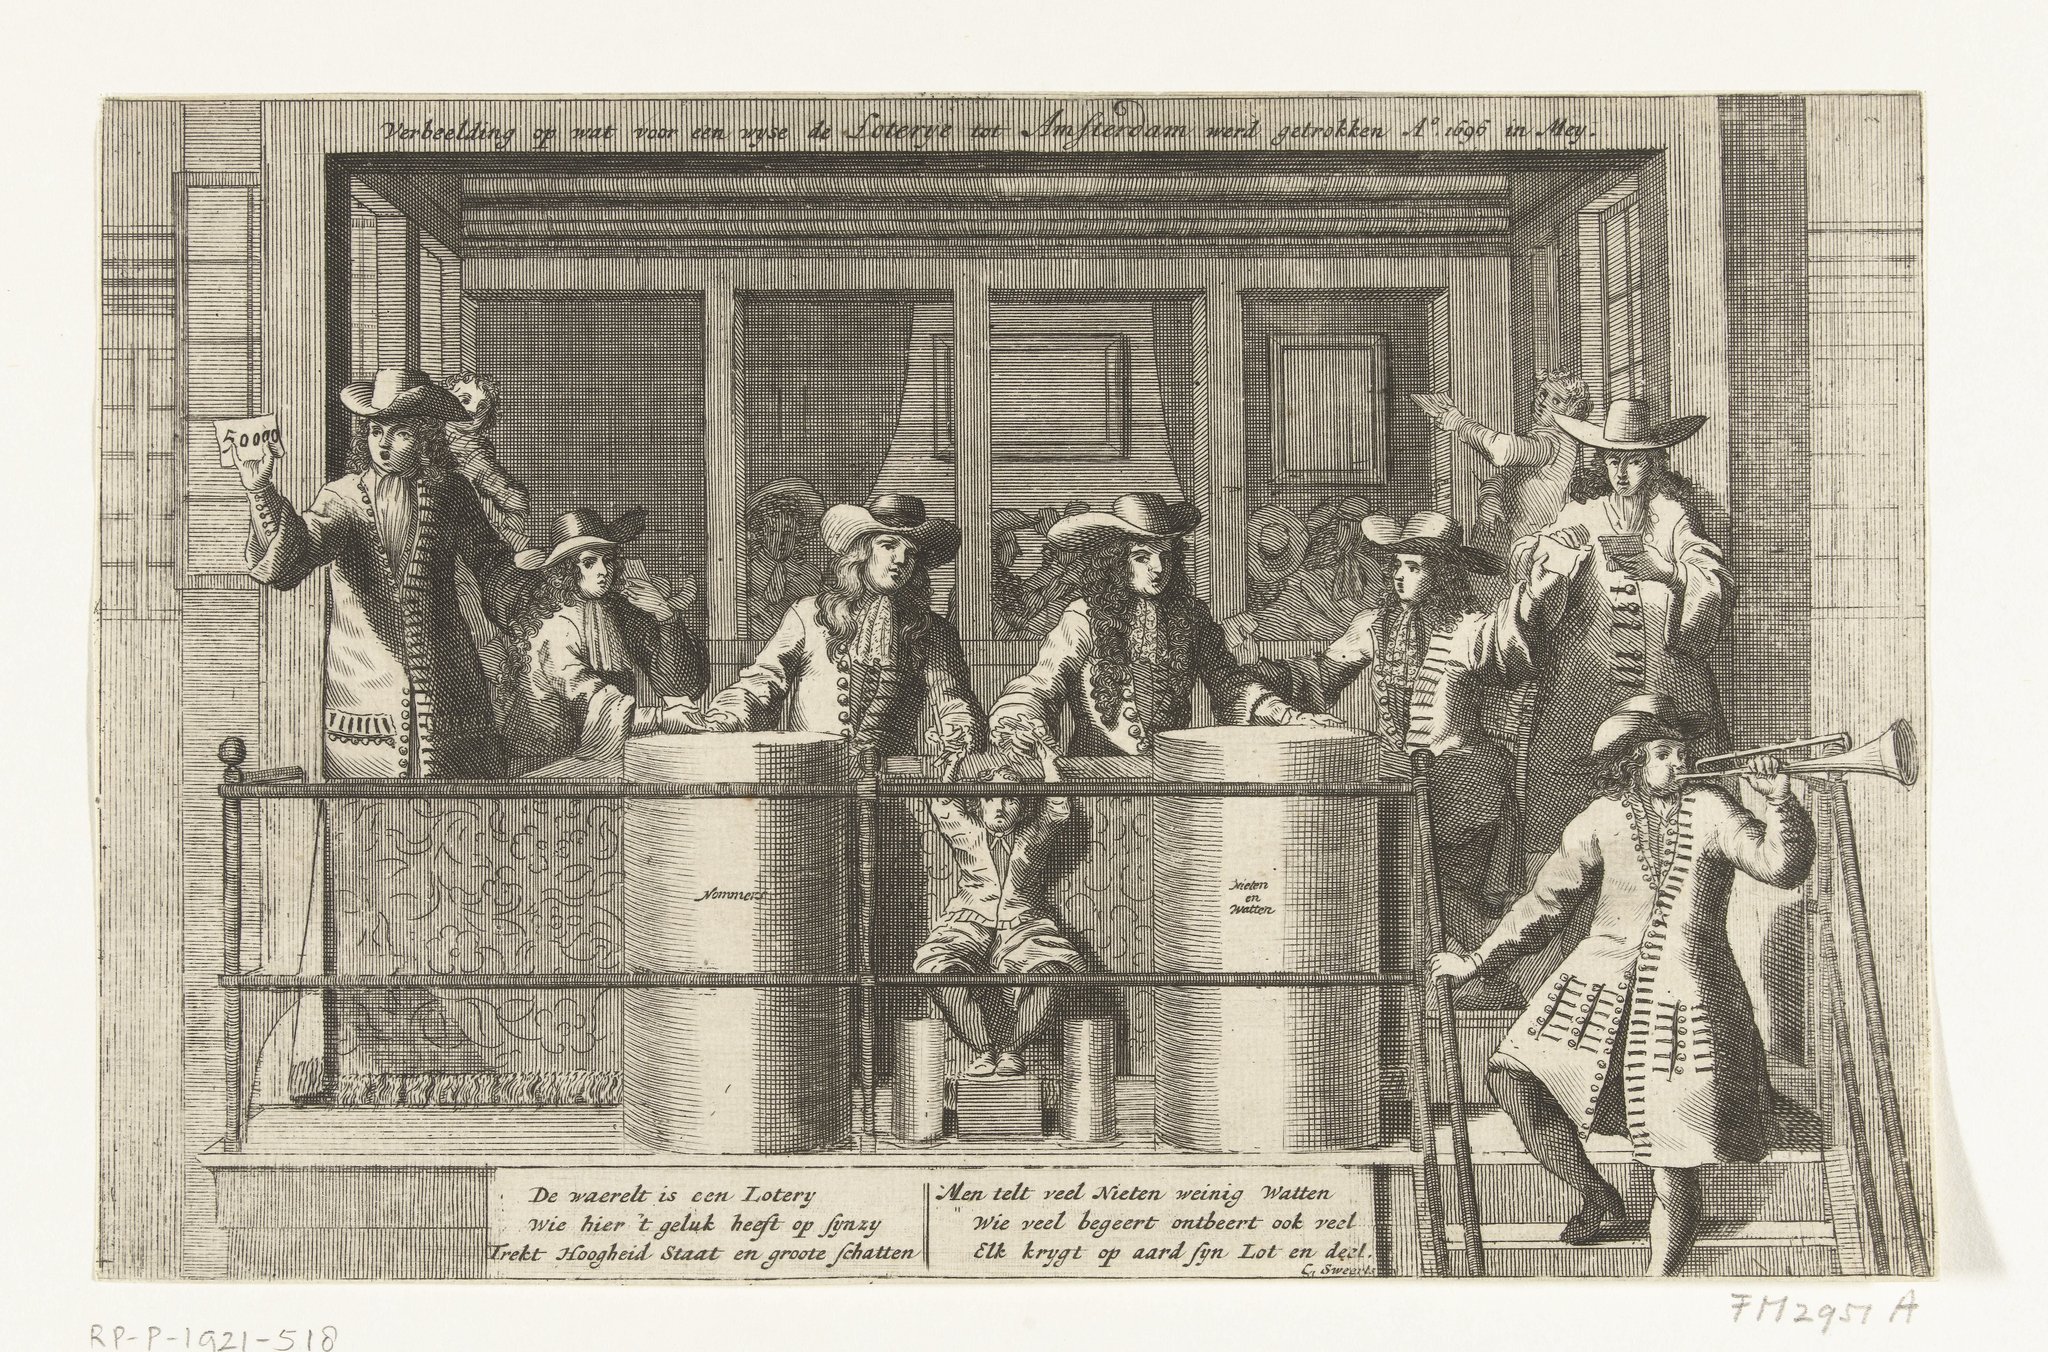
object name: print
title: Trekking van de loterij te Amsterdam, 1696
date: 1696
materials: paper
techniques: engraving, etching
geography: northern netherlands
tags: raffle, lottery, amsterdam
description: Trekking van de loterij te Amsterdam, mei 1696. Op een open gallerij staan twee grote vaten. Rechts de Nieten en Watten, links de Nommers. Een jongetje trekt uit elk een lot en geeft deze naar achteren door. Hier worden de winnaars opgeschreven en uitgeroepen. Onder de voorstelling een vers in twee kolommen van elk drie regels op de wereld als lotterij. Afgesneden exemplaar zonder namen.